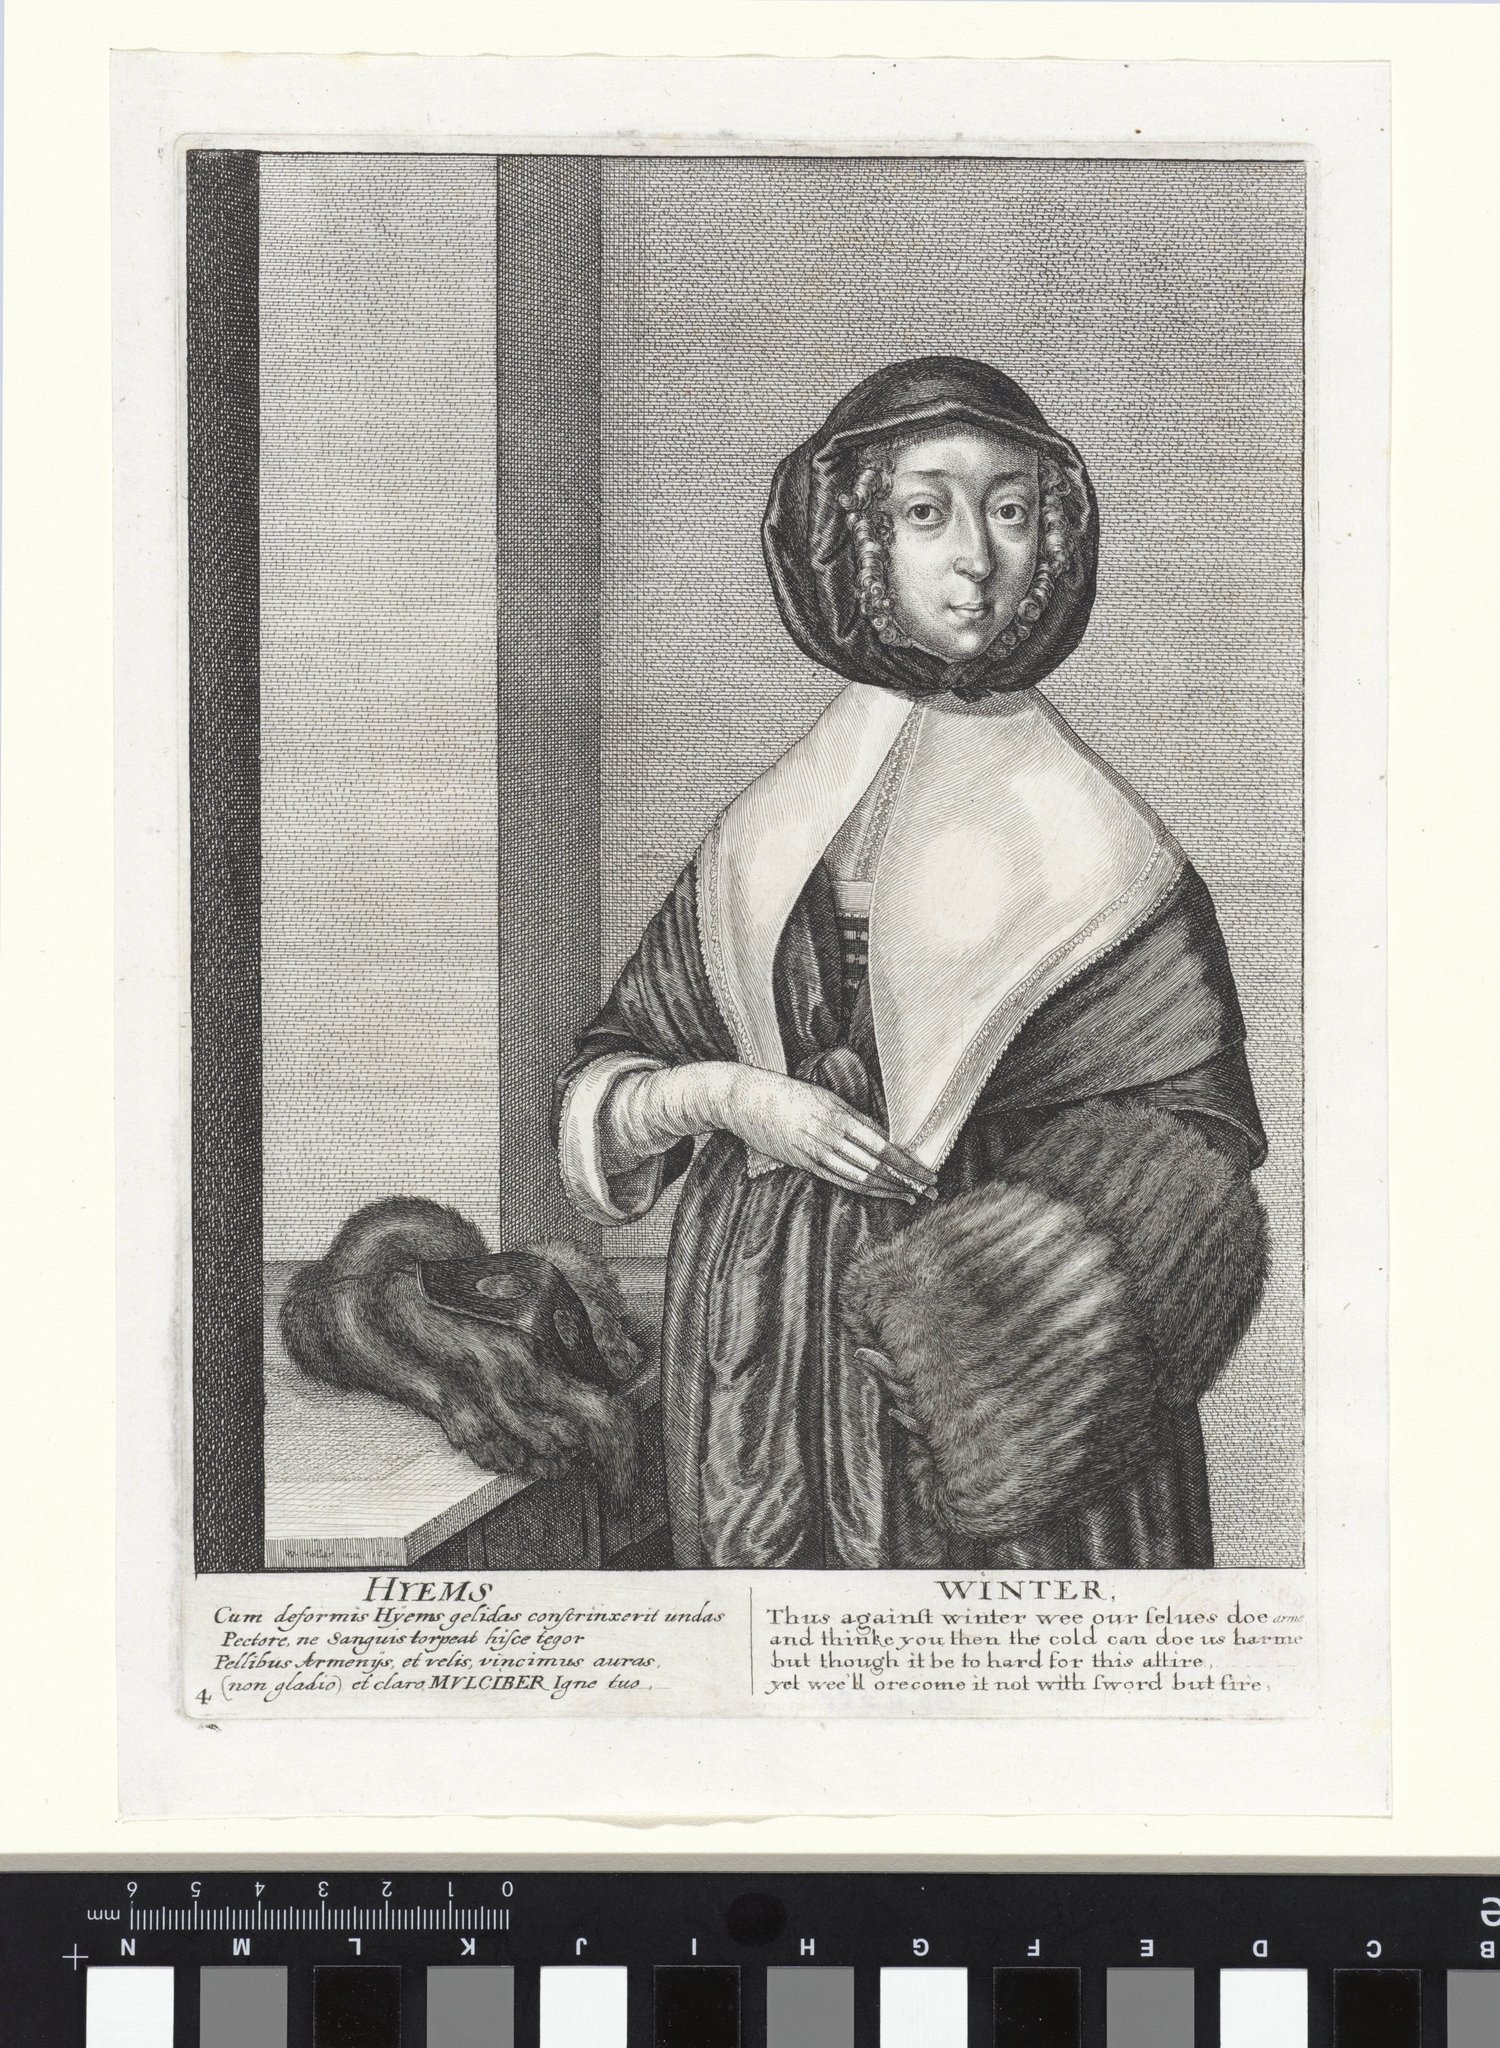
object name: print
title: De vier seizoenen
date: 1641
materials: paper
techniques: etching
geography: london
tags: winter, 'hyems'; 'inverno' (ripa), head-gear: cap (+ women's clothes), neck-gear: collar (+ women's clothes), clothes, costume (+ women's clothes), gloves, mittens, etc. (+ women's clothes), muff (+ women's clothes)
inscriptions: collector's mark: Lugt 240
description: Staande vrouw met mof en masker als personificatie van de Winter.